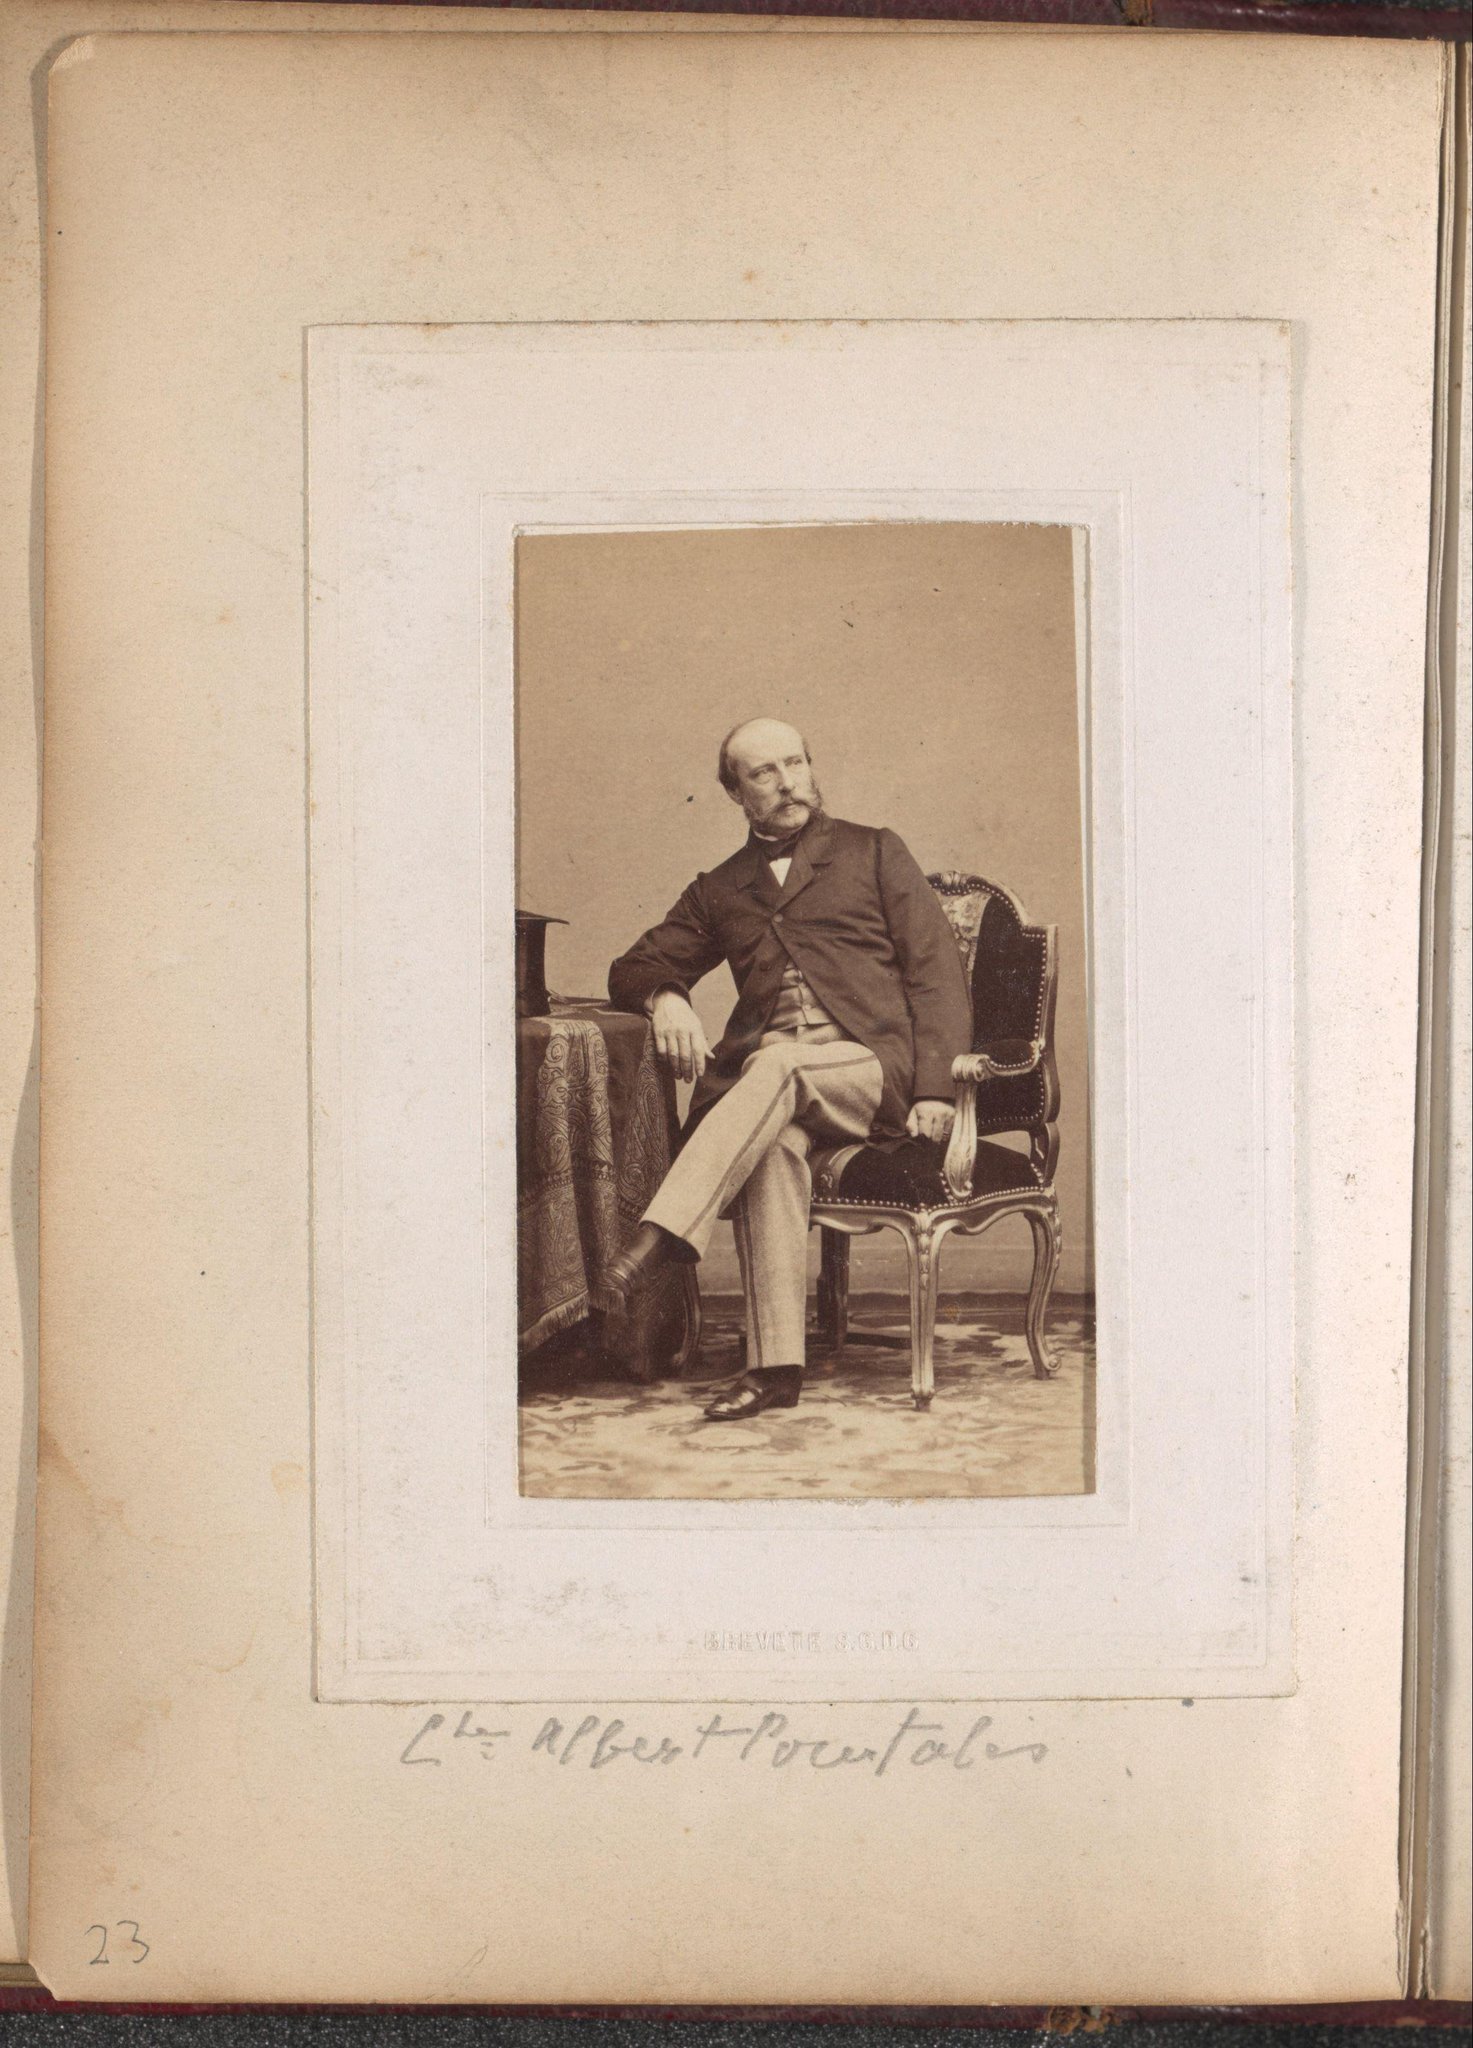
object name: carte de visite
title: Portret van graaf Albert de Pourtalès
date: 1860-1861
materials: cardboard, paper, photographic support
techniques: albumen print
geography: paris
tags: paris, studio requisites ~ photographer, trousers, breeches, moustache, historical persons, neck-gear ~ clothing, baldness, shoes, sandals, coat, cape, head-gear: top hat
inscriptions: address: ‘8, Boulevart des Italiens, Paris’, name: ‘Cte. Albert Pourtales’, name: ‘Cte. Albert Pourtales’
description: Onderdeel van Fotoalbum met 48 cartes-de-visite aangeboden aan maarschalk graaf De Castellane.